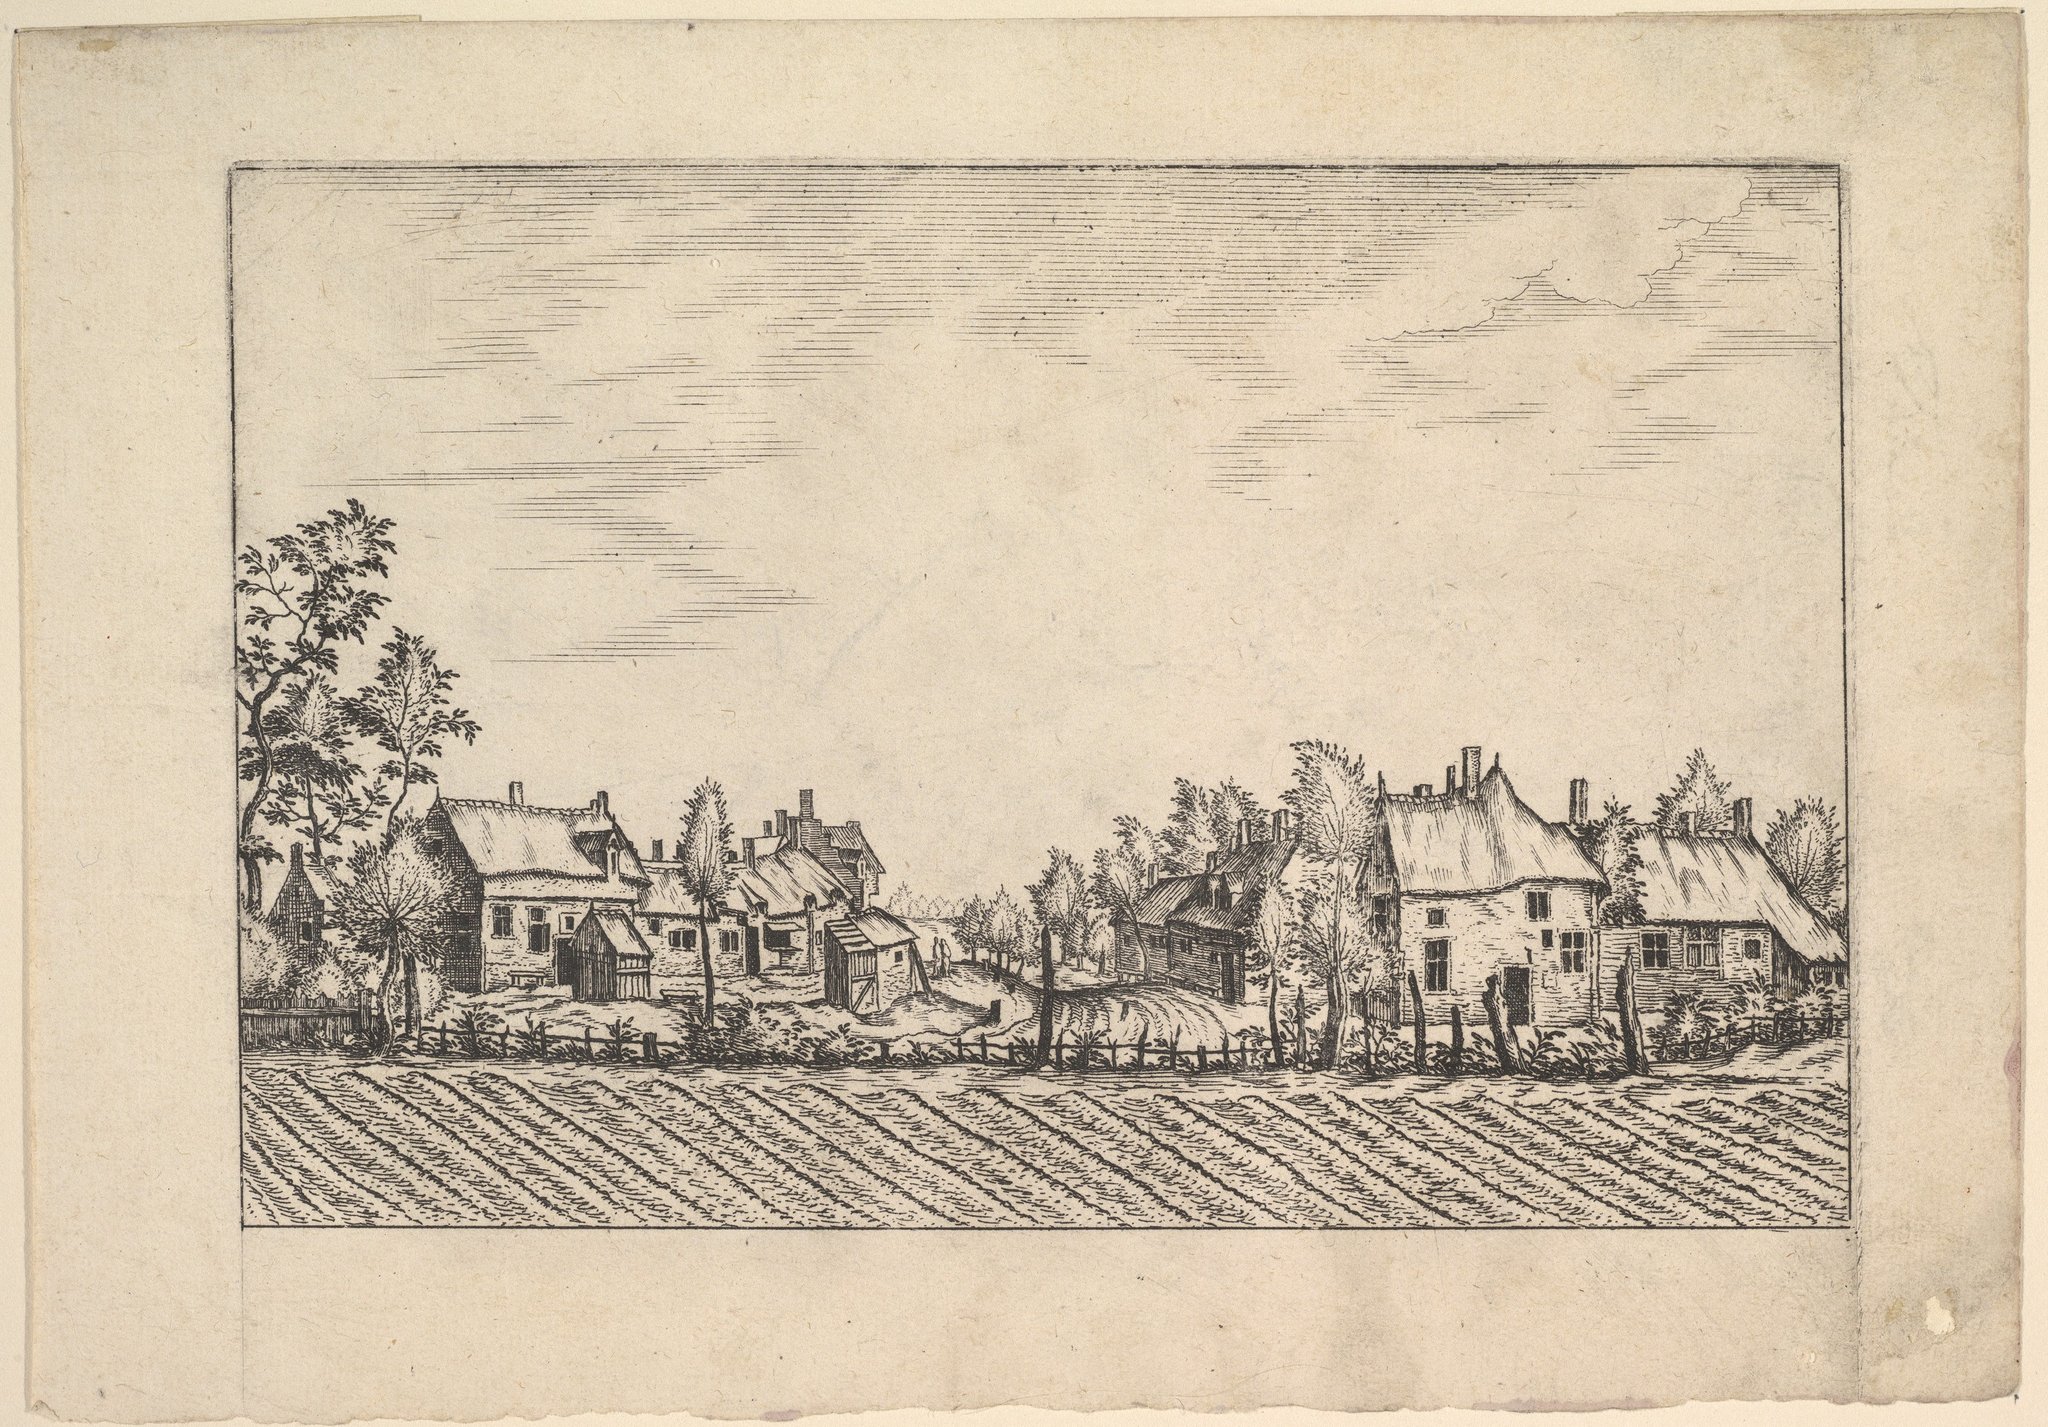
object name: print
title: Farms, ploughed field in the foreground from Praediorum villarum et rusticarum casularum icones elenoantissimae ad vivum in apre deformatae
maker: johannes van doetecum i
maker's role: artist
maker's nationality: netherlandish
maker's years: 1528-1605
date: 1559-1561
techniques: etching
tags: houses,farms